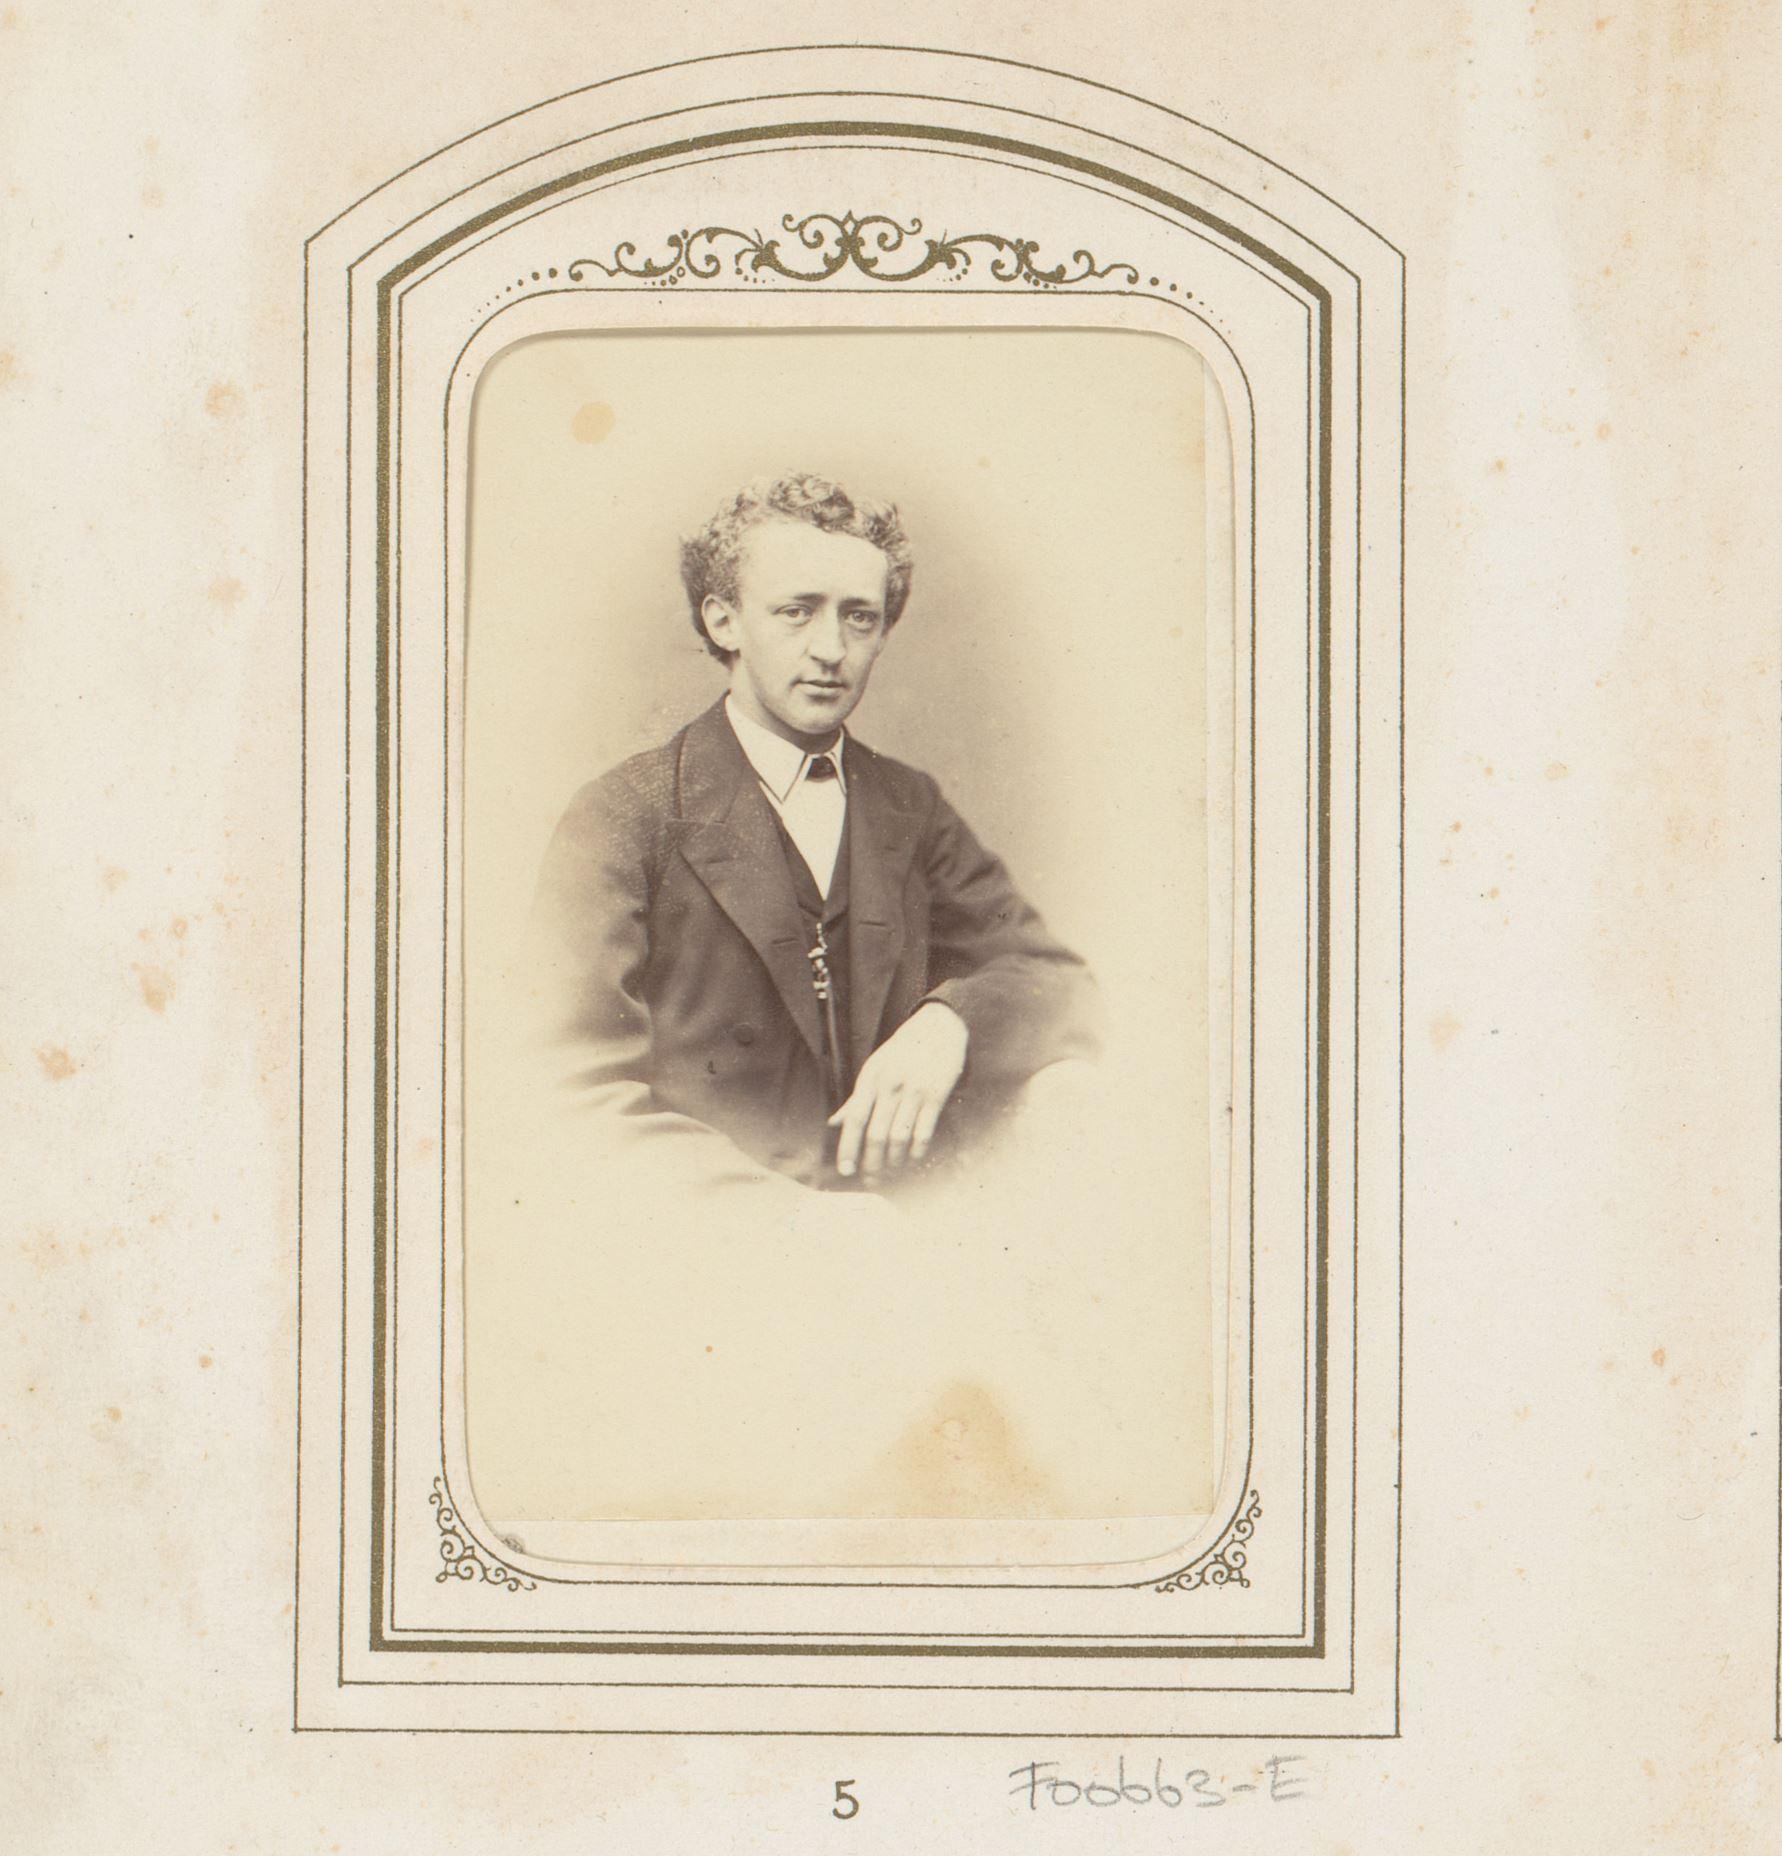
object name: album leaf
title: Portret van een zittende man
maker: albert greiner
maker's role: fotograaf, fotostudio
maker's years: 1833-1890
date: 1861-1874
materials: cardboard, photographic support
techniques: albumen print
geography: amsterdam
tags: historical persons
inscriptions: inscription: ‘A. Greiner/ photograf/ Nieuwendijk. L.87/ Amsterdam’, number: ‘5’